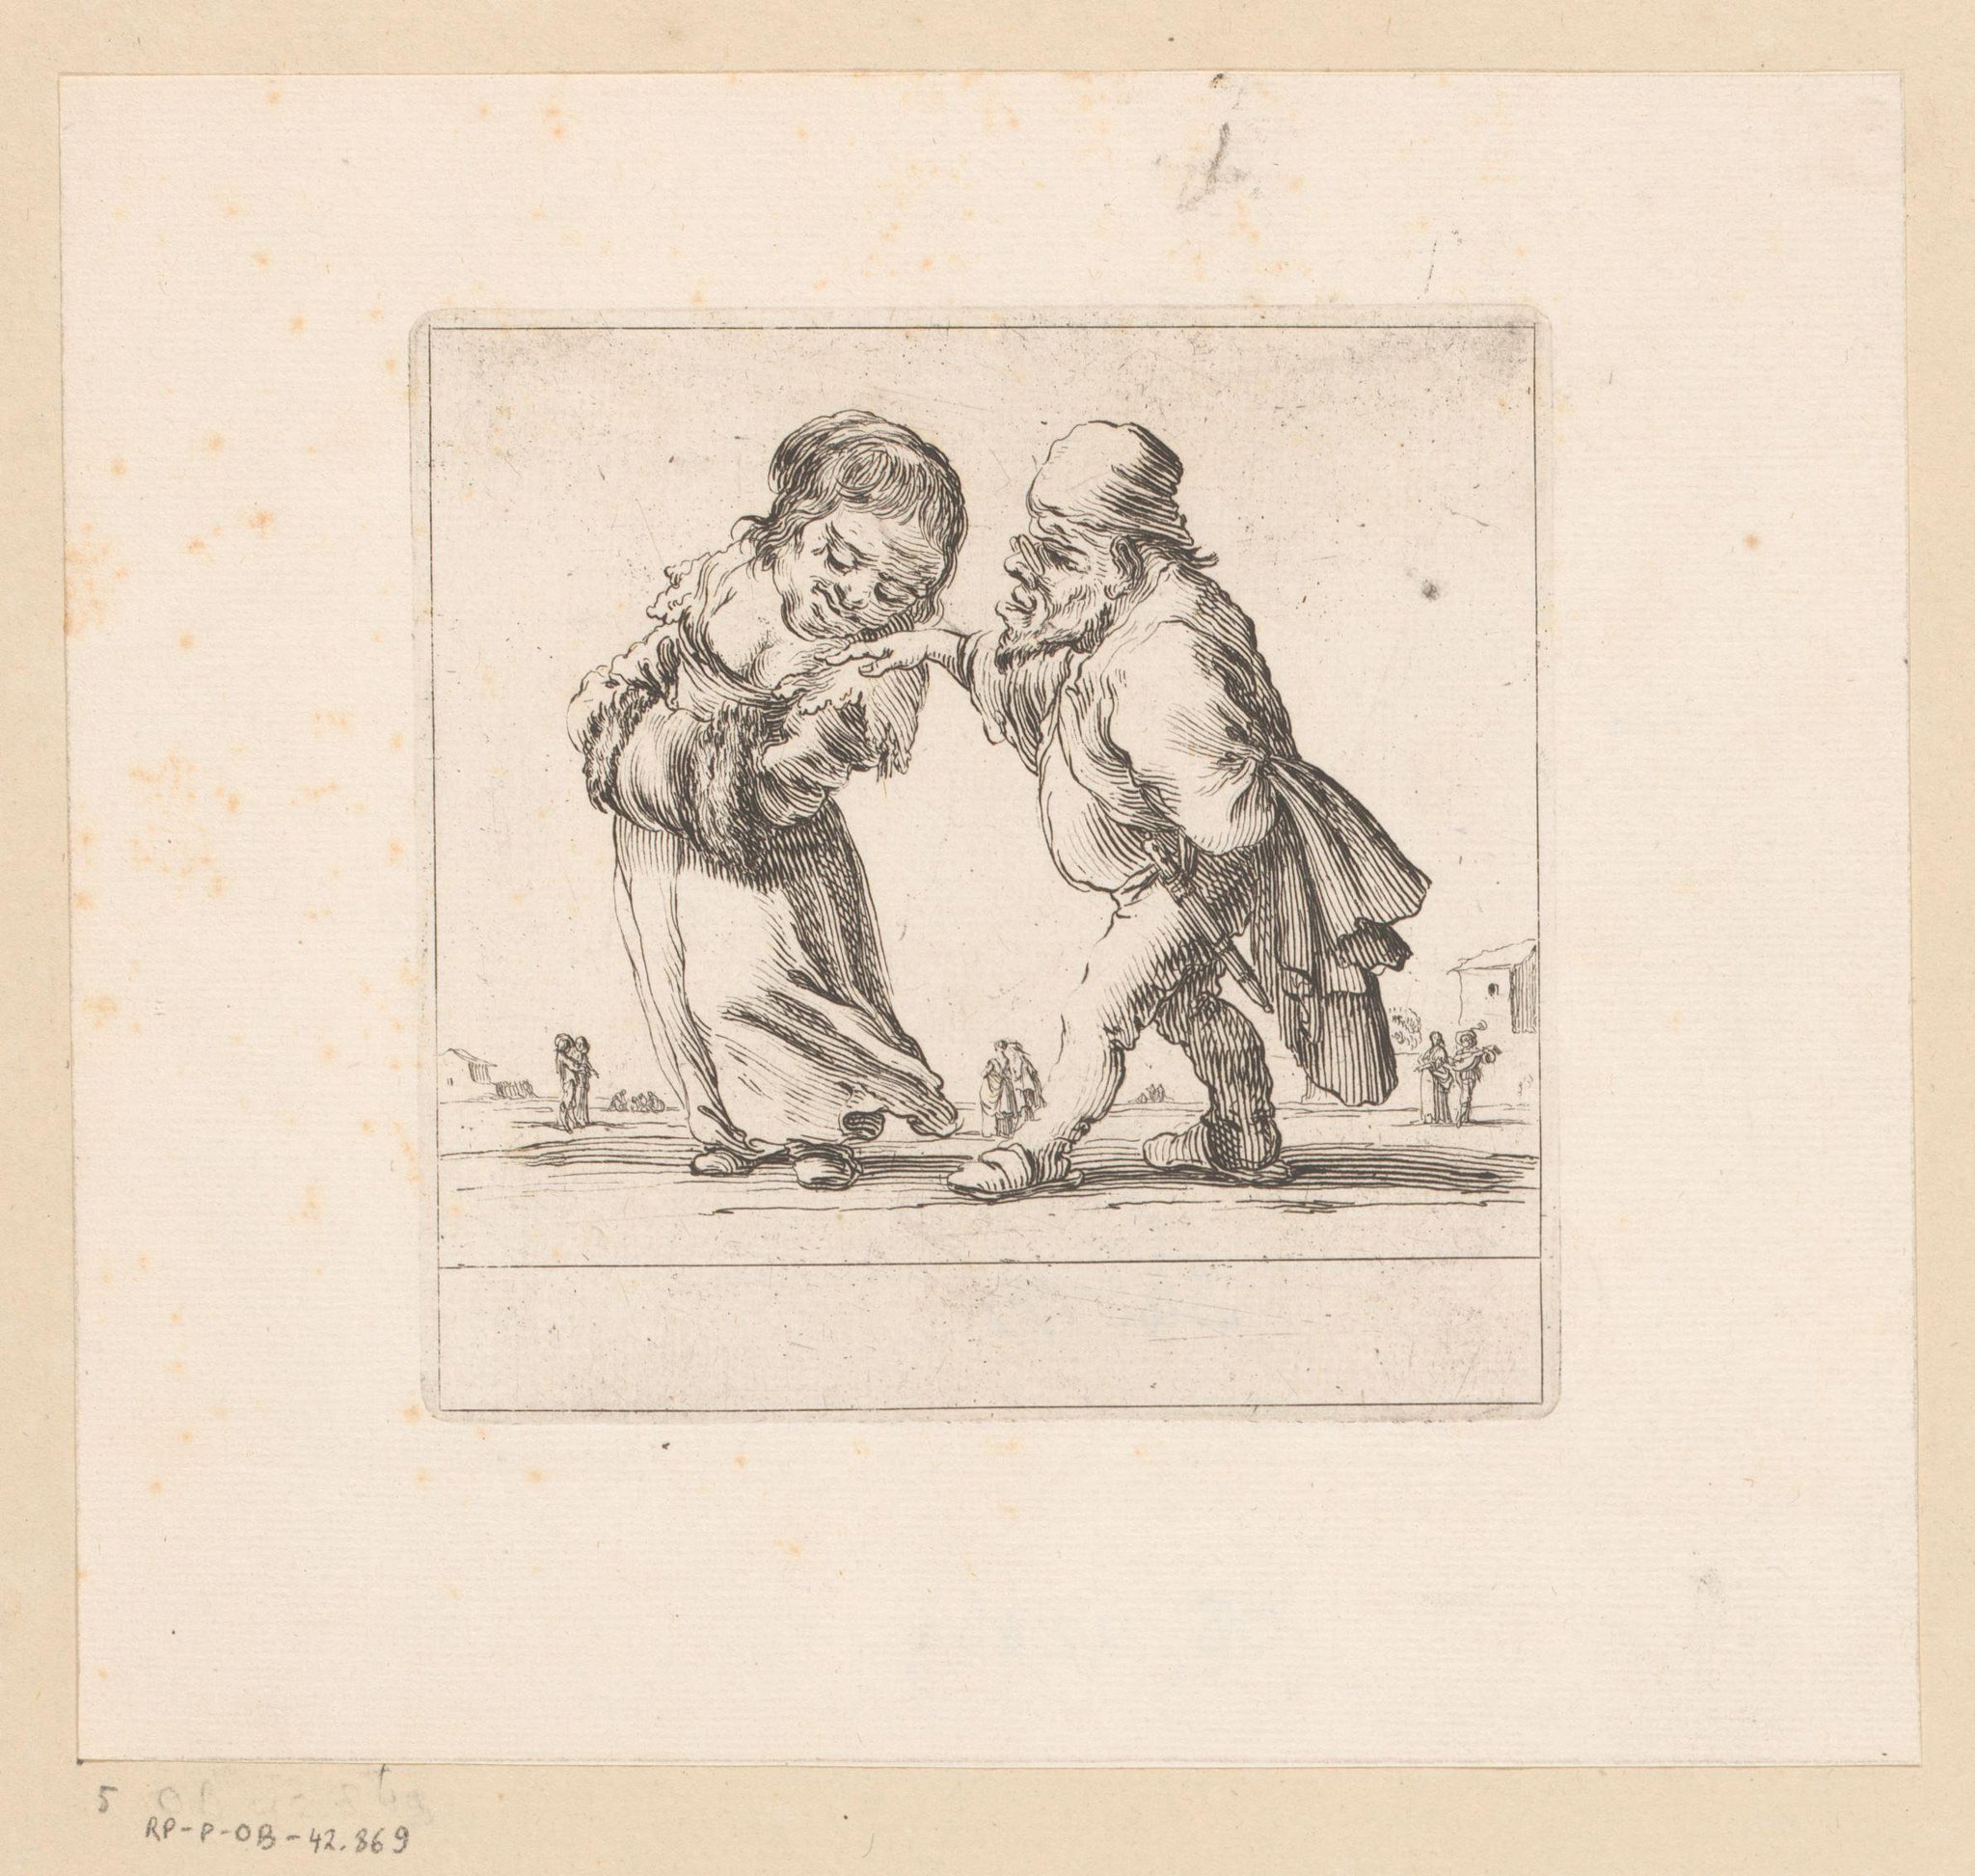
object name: print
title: Serie met karikaturale figuren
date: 1620-1687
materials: paper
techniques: engraving, etching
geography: italy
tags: caricatures (human types), couple of lovers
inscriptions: collector's mark: Lugt 240